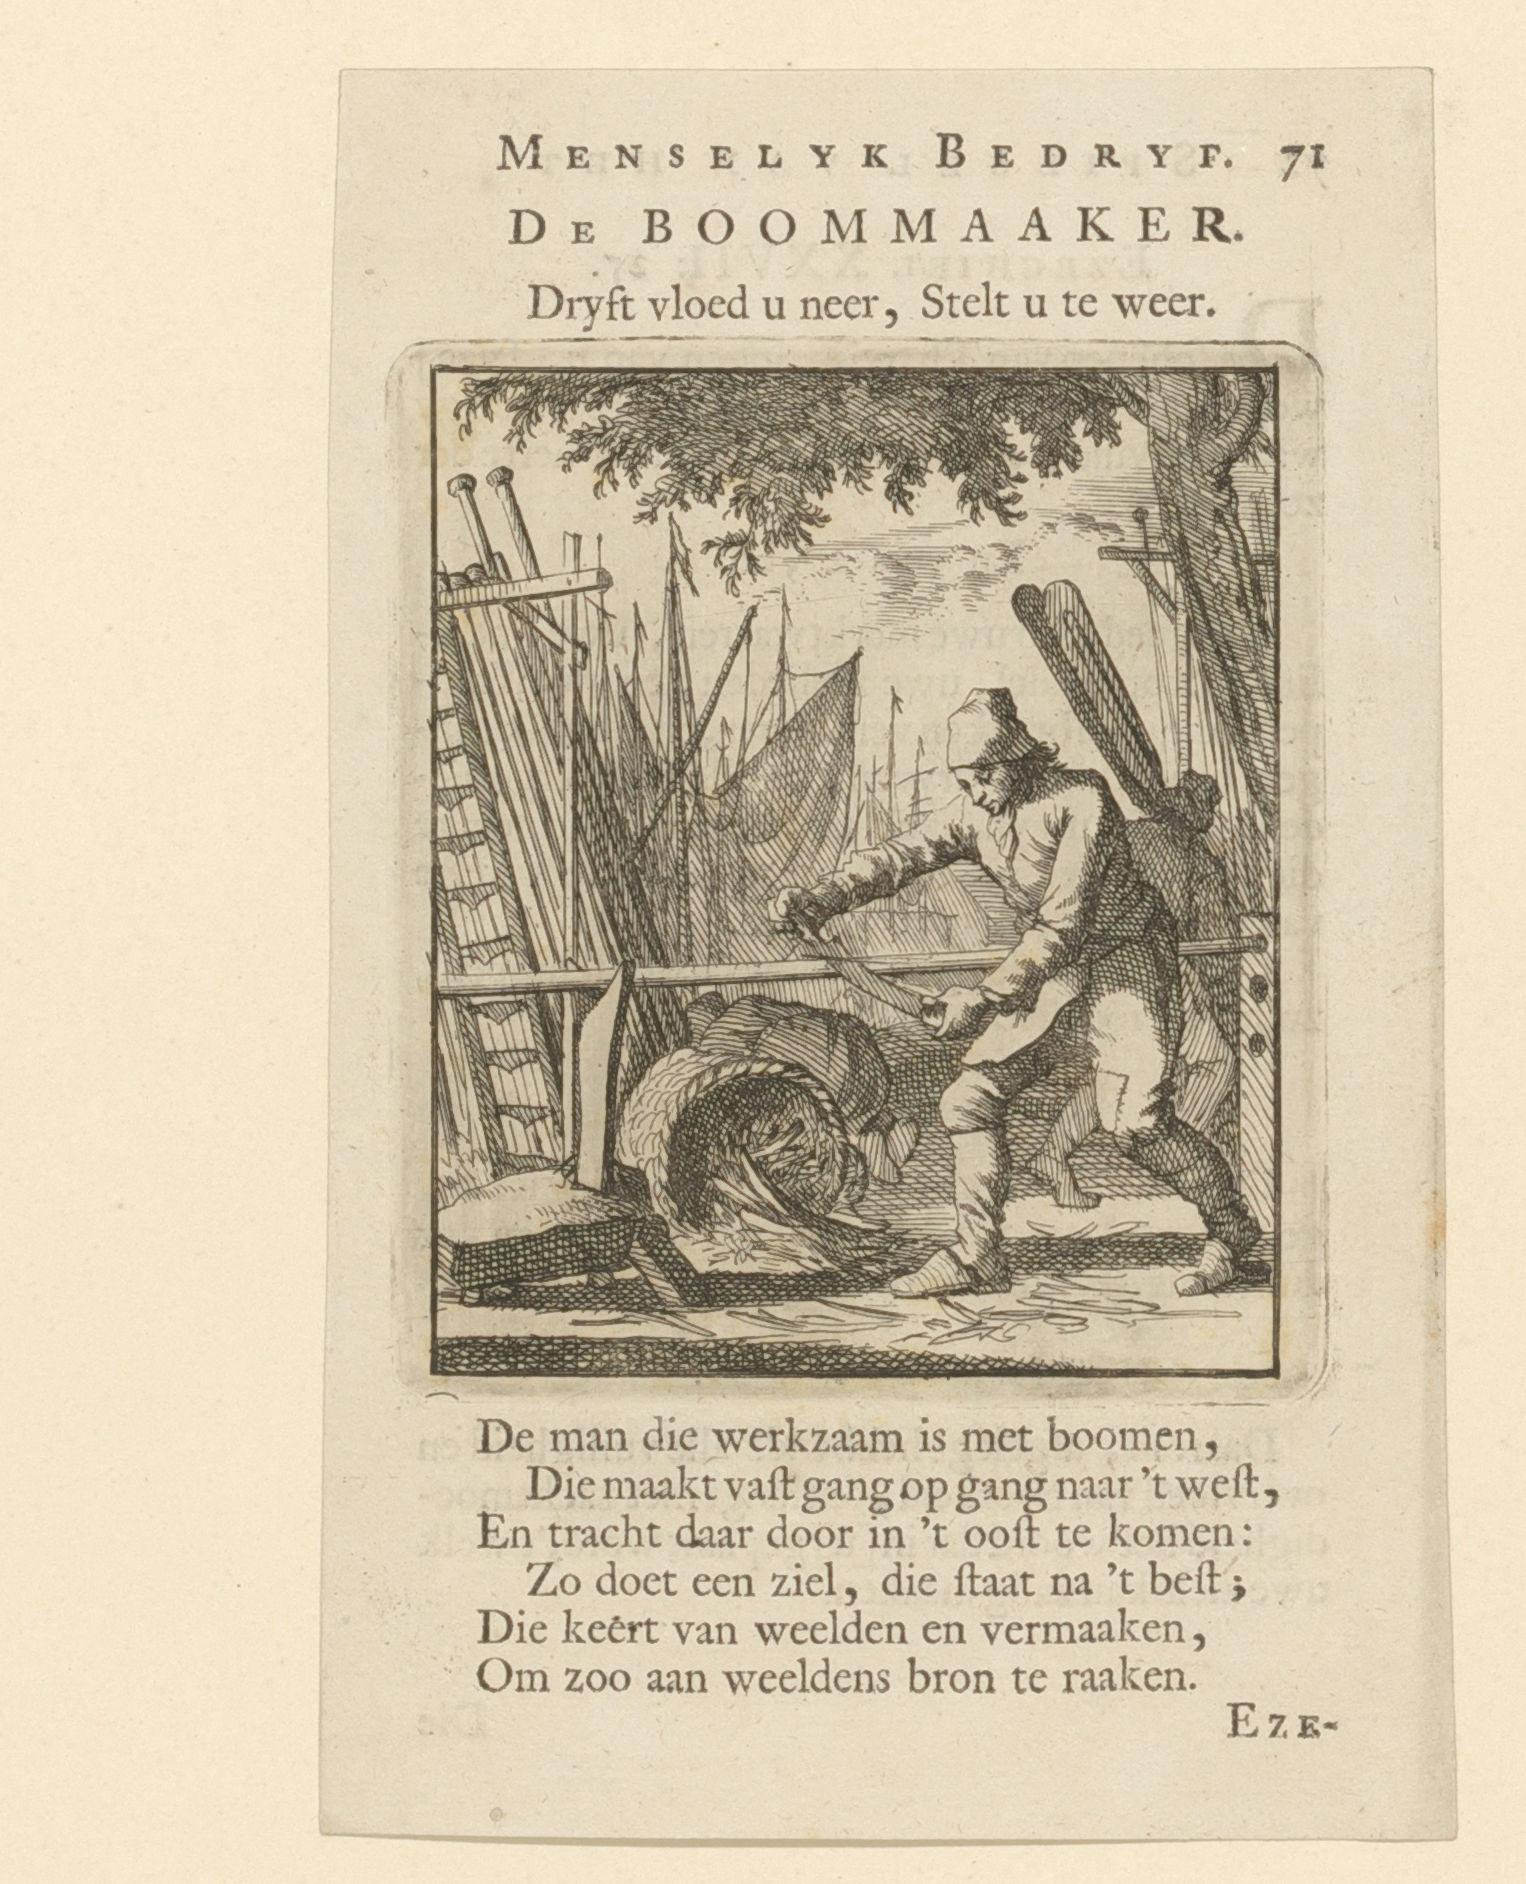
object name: book illustration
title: Boommaker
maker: cornelis van der sys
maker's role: publisher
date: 1718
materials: paper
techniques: etching, letterpress printing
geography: amsterdam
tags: handicrafts, craftsman at work, poling, punting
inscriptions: stamp, collector's mark: Lugt 1641, stamp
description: Prent oorspronkelijk verschenen in de 100-delige serie beroepsprenten van Jan en Caspar Luyken, getiteld: Het menselyk bedryf. S.l.s.n., 1694 (eerste druk). Huidige staat uit: Luyken, Jan en Caspar. Spiegel van het menselyk bedryf (...). Amsterdam: Cornelis van der Sys, 1718, p. 71. Prent waarschijnlijk ook gebruikt in eerdere (1704) en latere (1730, 1749, 1767) publicaties.